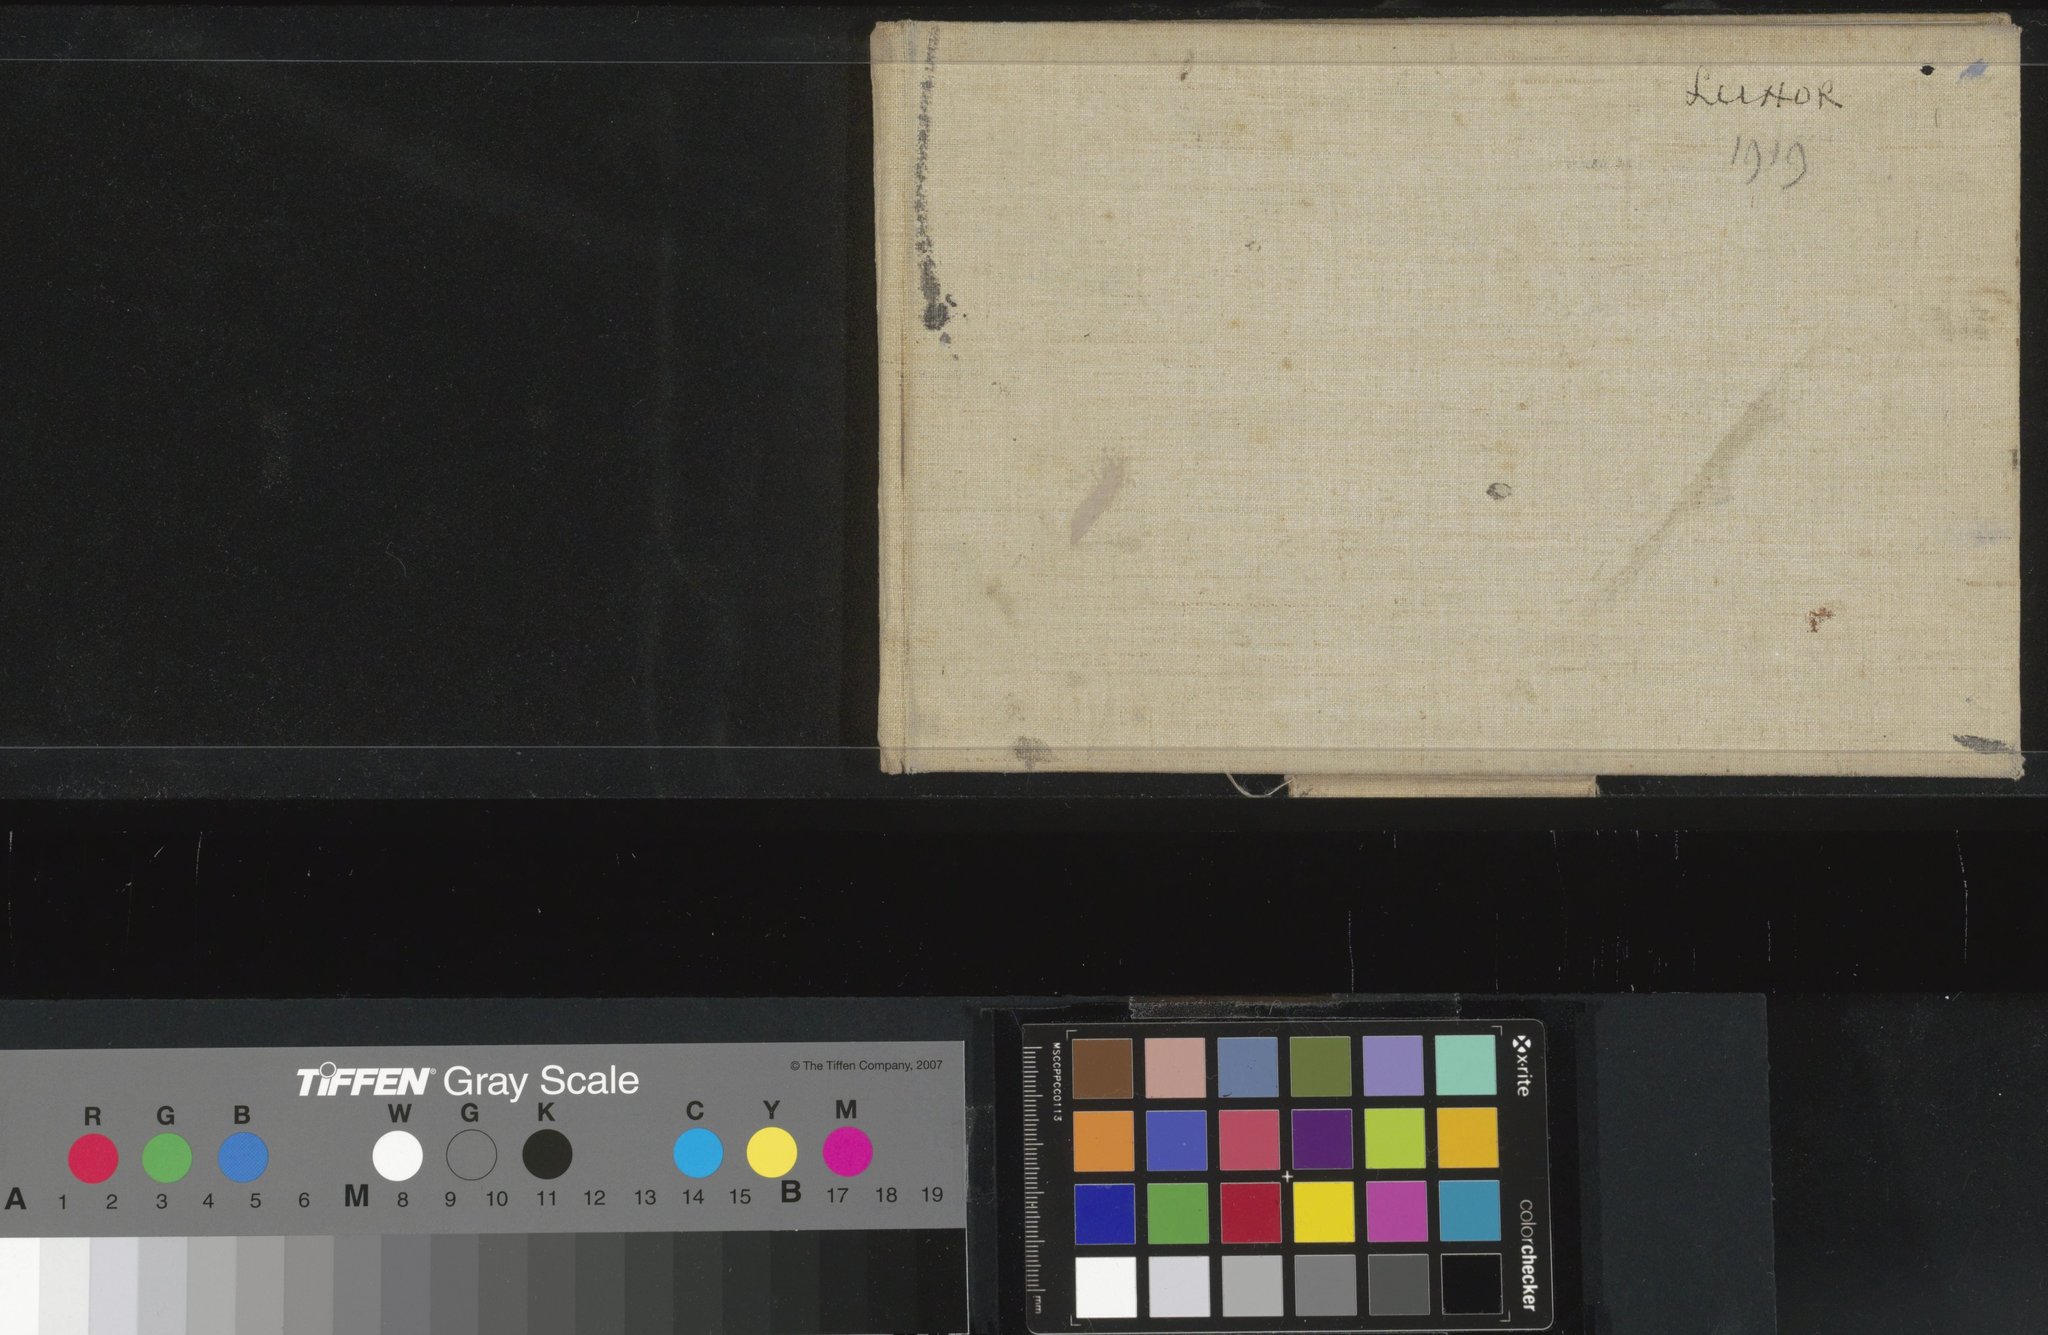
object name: sketchbook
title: Schetsboek met 18 bladen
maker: marius bauer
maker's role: draughtsman, print maker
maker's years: 1867-1932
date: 1919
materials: cardboard, chalk, linen, paper, pastel, watercolor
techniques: brush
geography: luxor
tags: temple, shrine ~ egyptian religion, river, africans, desert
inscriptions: date: ‘LUXOR/ 1919’, collector's mark: Lugt 2228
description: Schetsboek bestaande uit 18 bladen gemaakt in Luxor en omgeving met schetsen van woestijnlandschappen, straatscènes, landarbeiders bij de Nijl, tempels en figuurstudies van Egyptenaren.